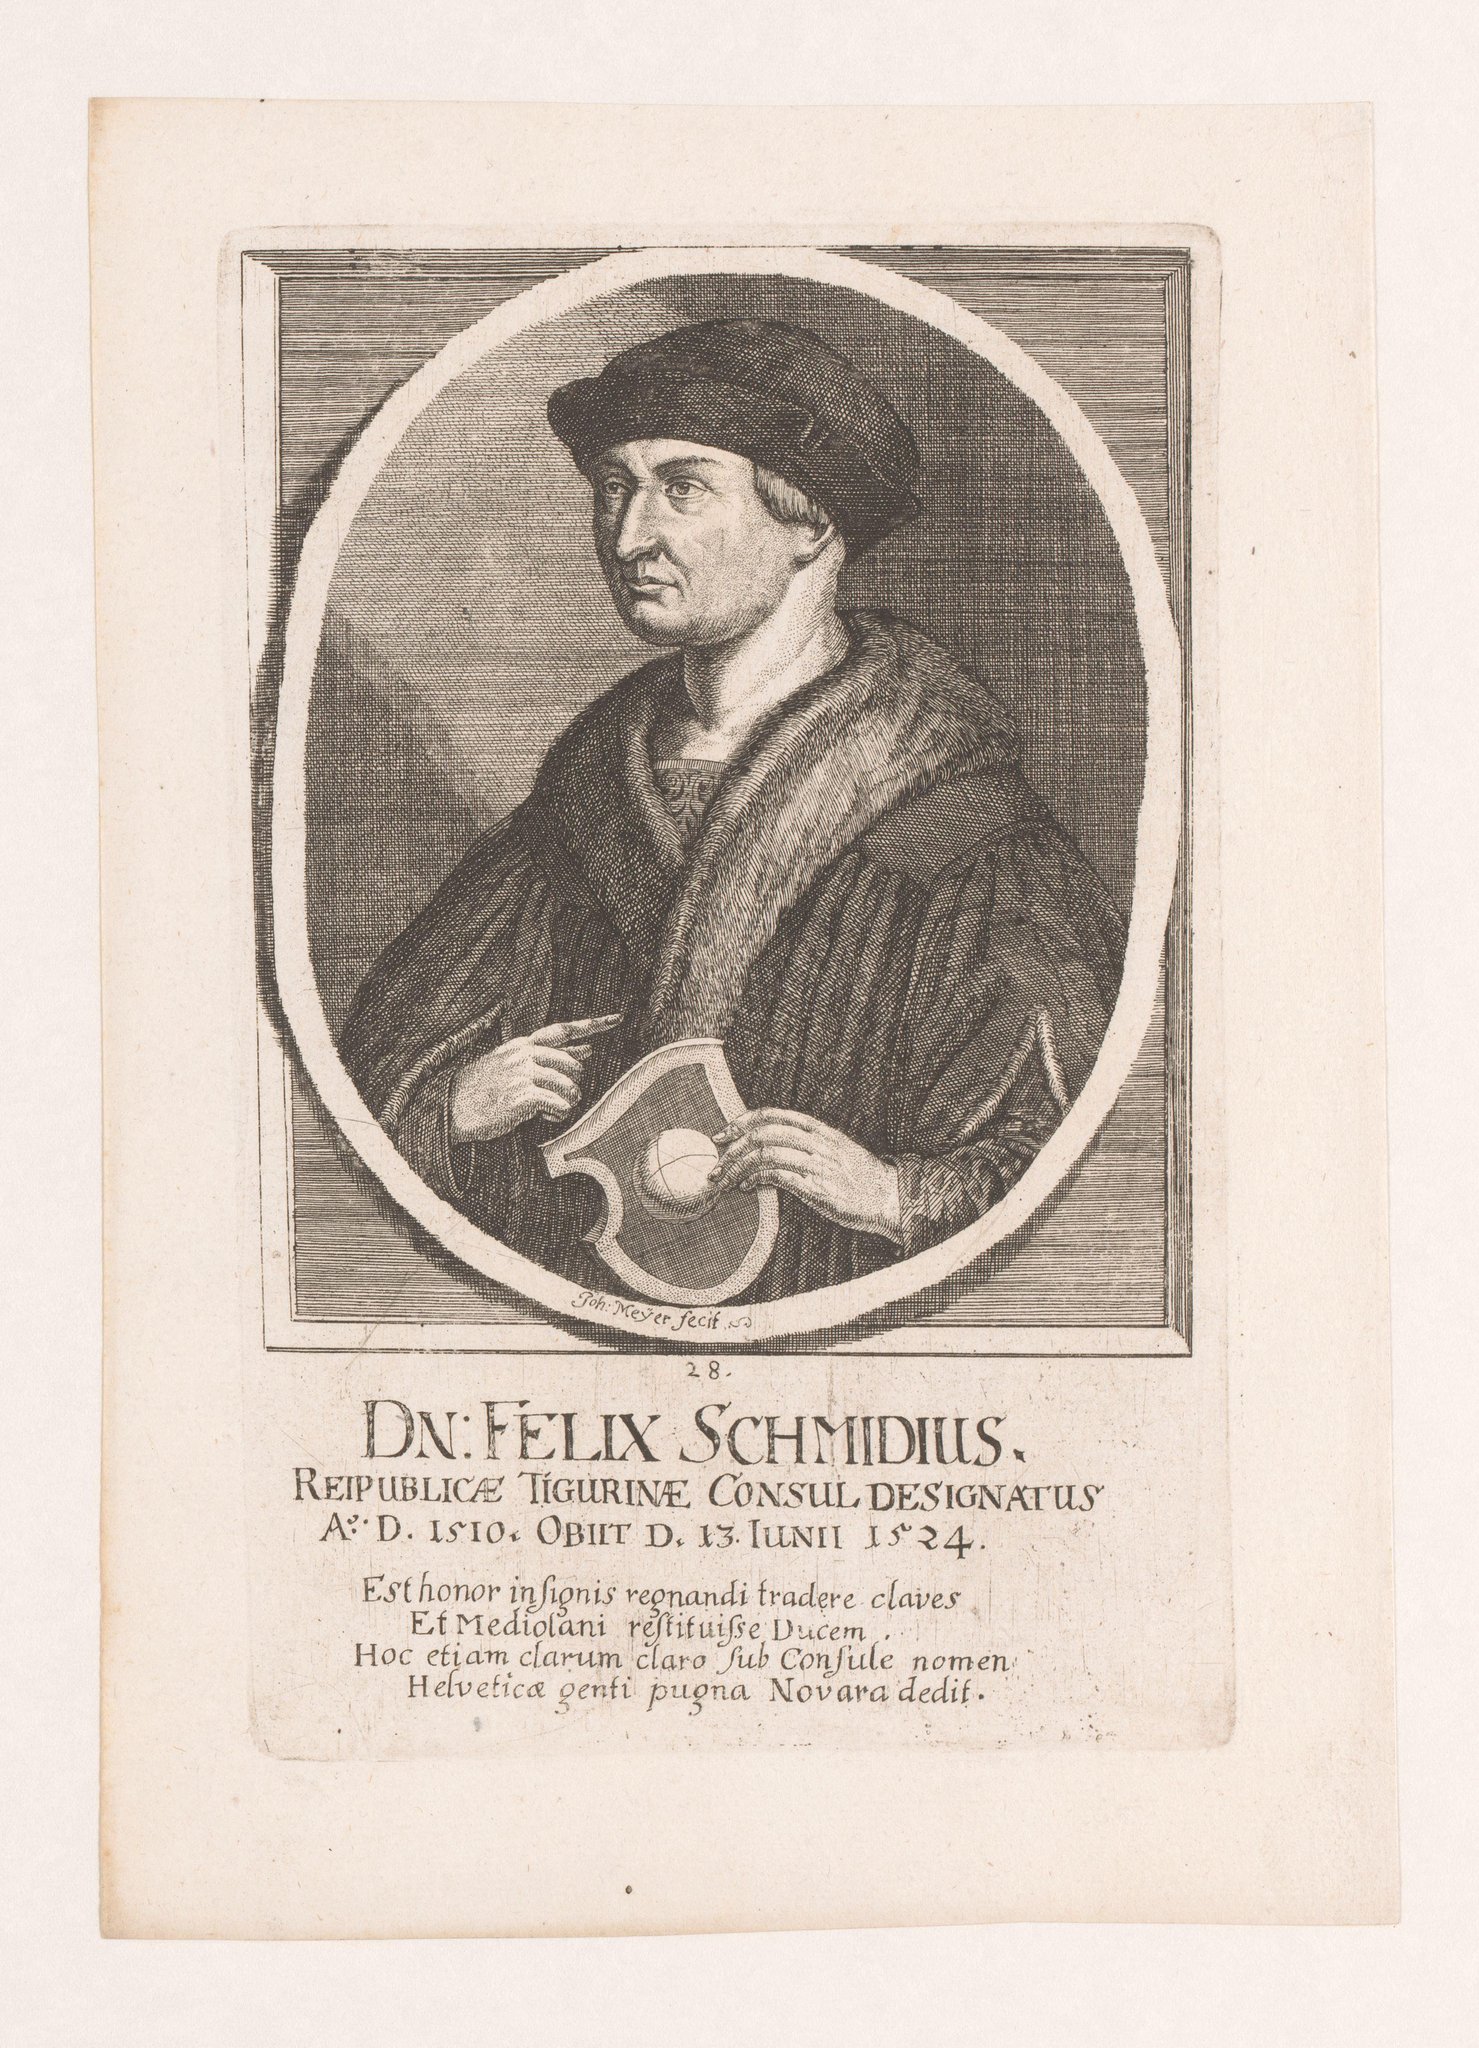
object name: print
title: Portret van Felix Schmid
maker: johannes meyer (ii)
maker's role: print maker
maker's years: 1655-1712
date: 1665-1712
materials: paper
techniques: engraving, etching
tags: mayor, mayor, burgomaster, historical persons, armorial bearing, heraldry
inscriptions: collector's mark: Lugt 2228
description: Onderaan de ovale omlijsting genummerd: 28.